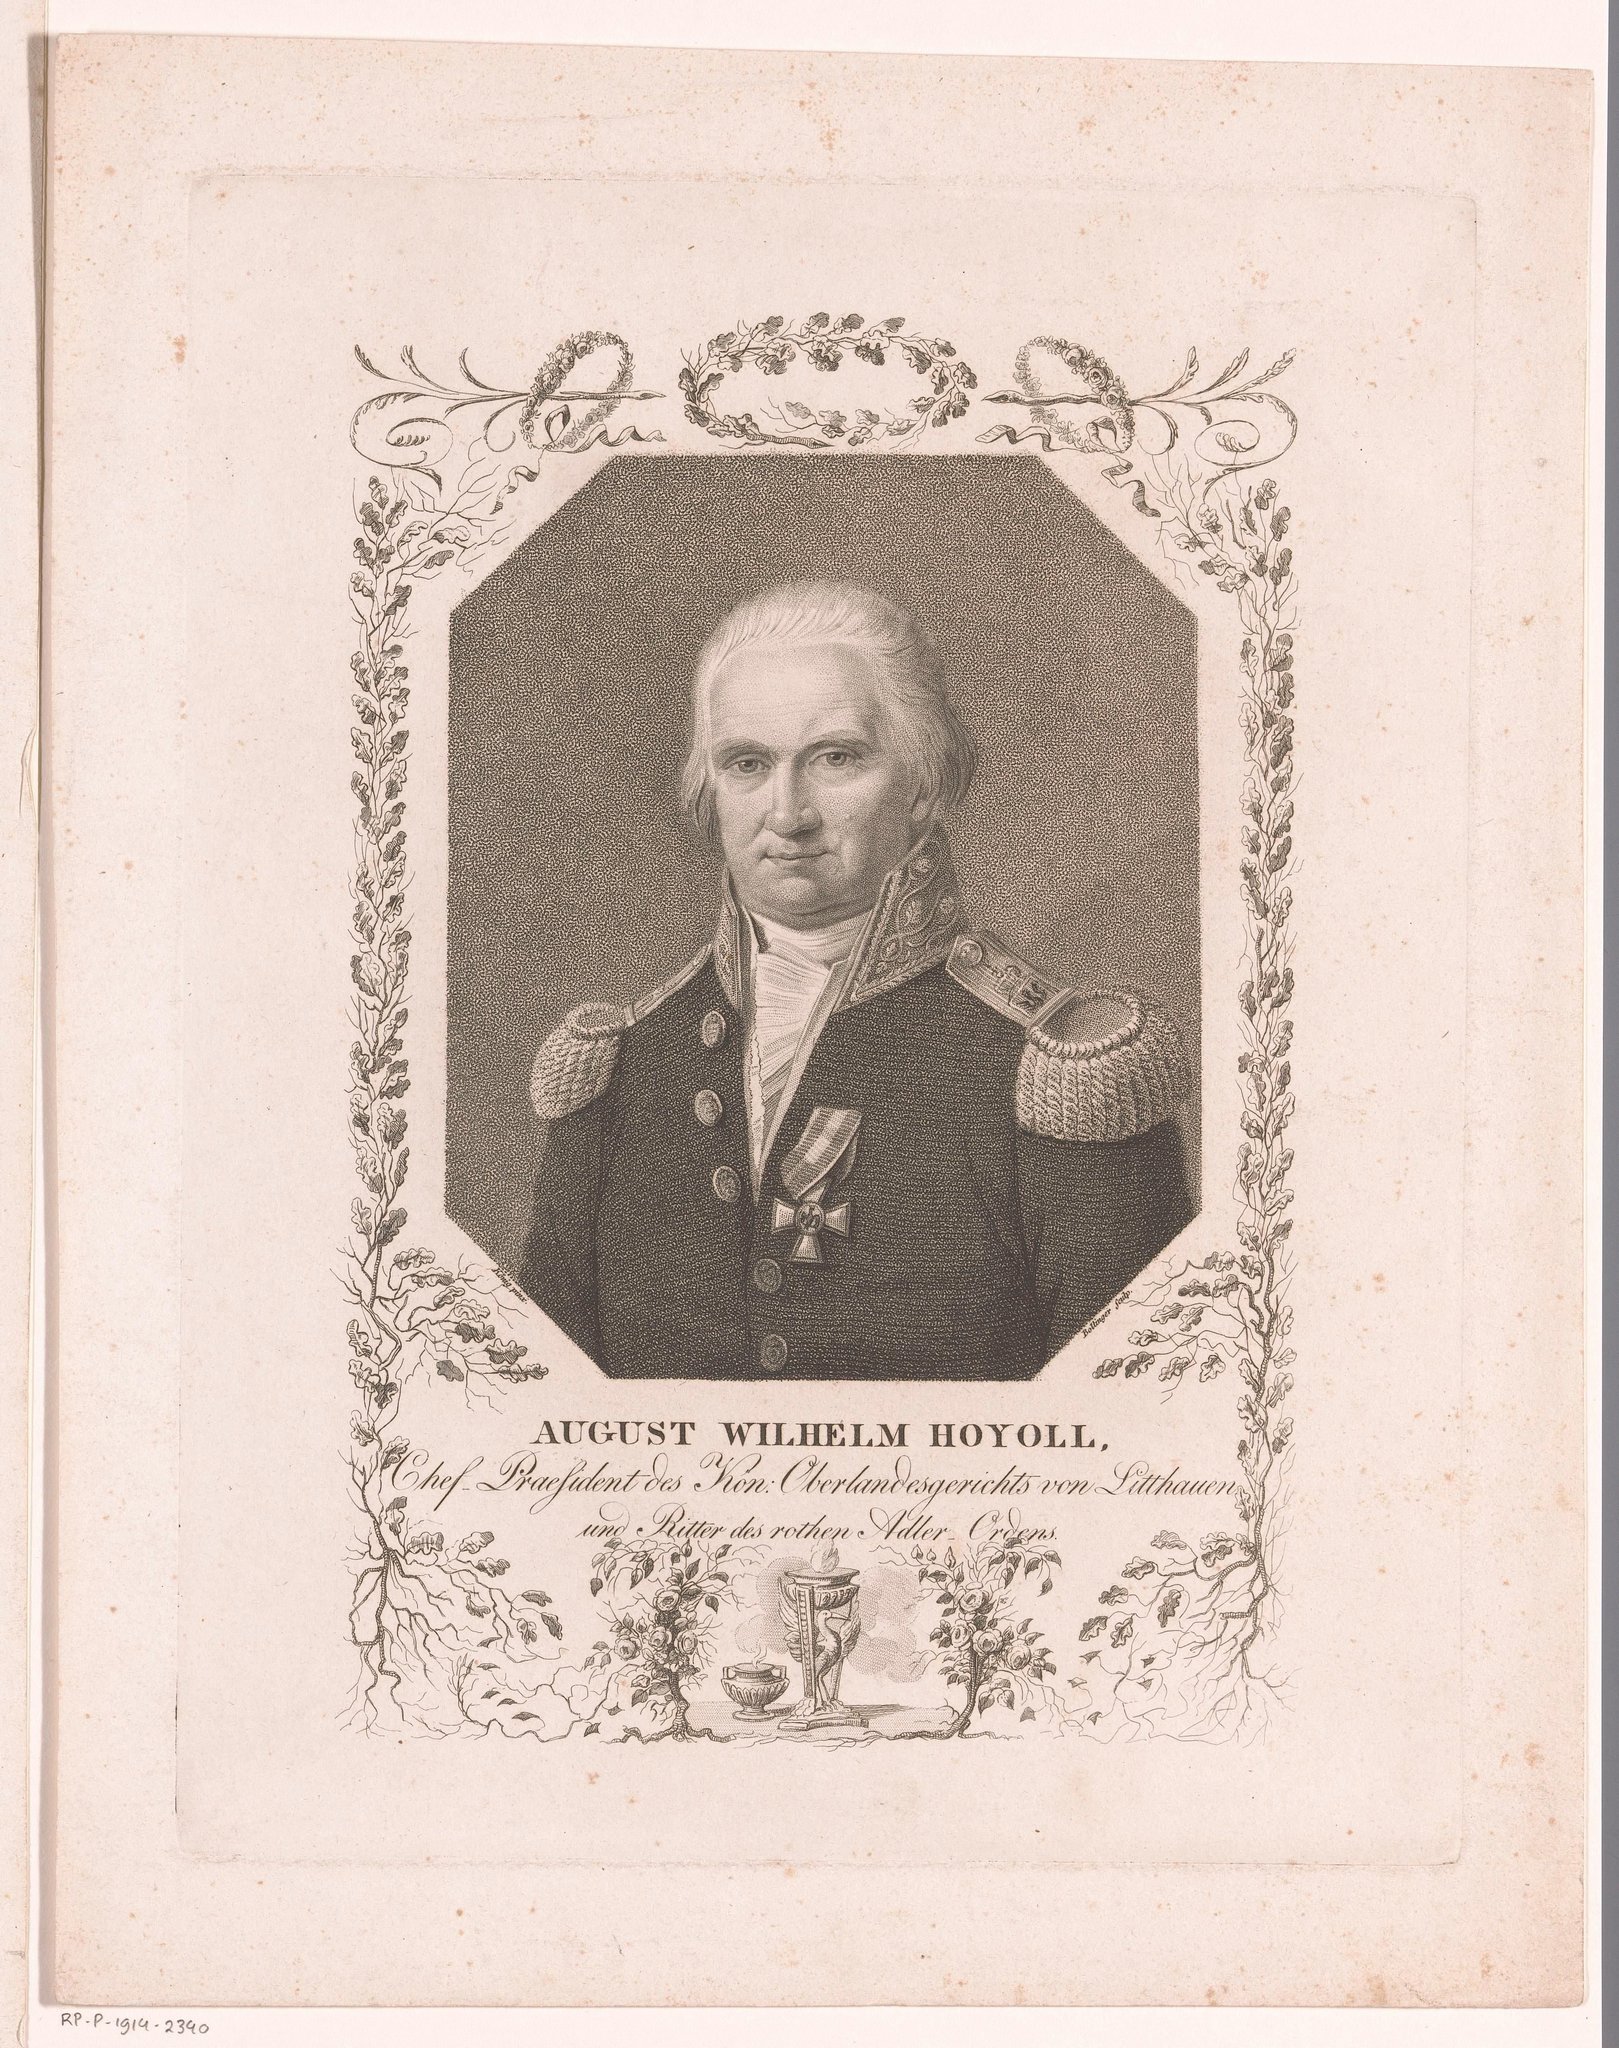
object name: print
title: Portret van August Wilhelm Hoyoll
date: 1810-1825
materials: paper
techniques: etching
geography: berlin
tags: knighthood order, historical persons, incense-burner ~ scents, perfumes, ornament derived from plant forms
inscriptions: collector's mark: Lugt 2228